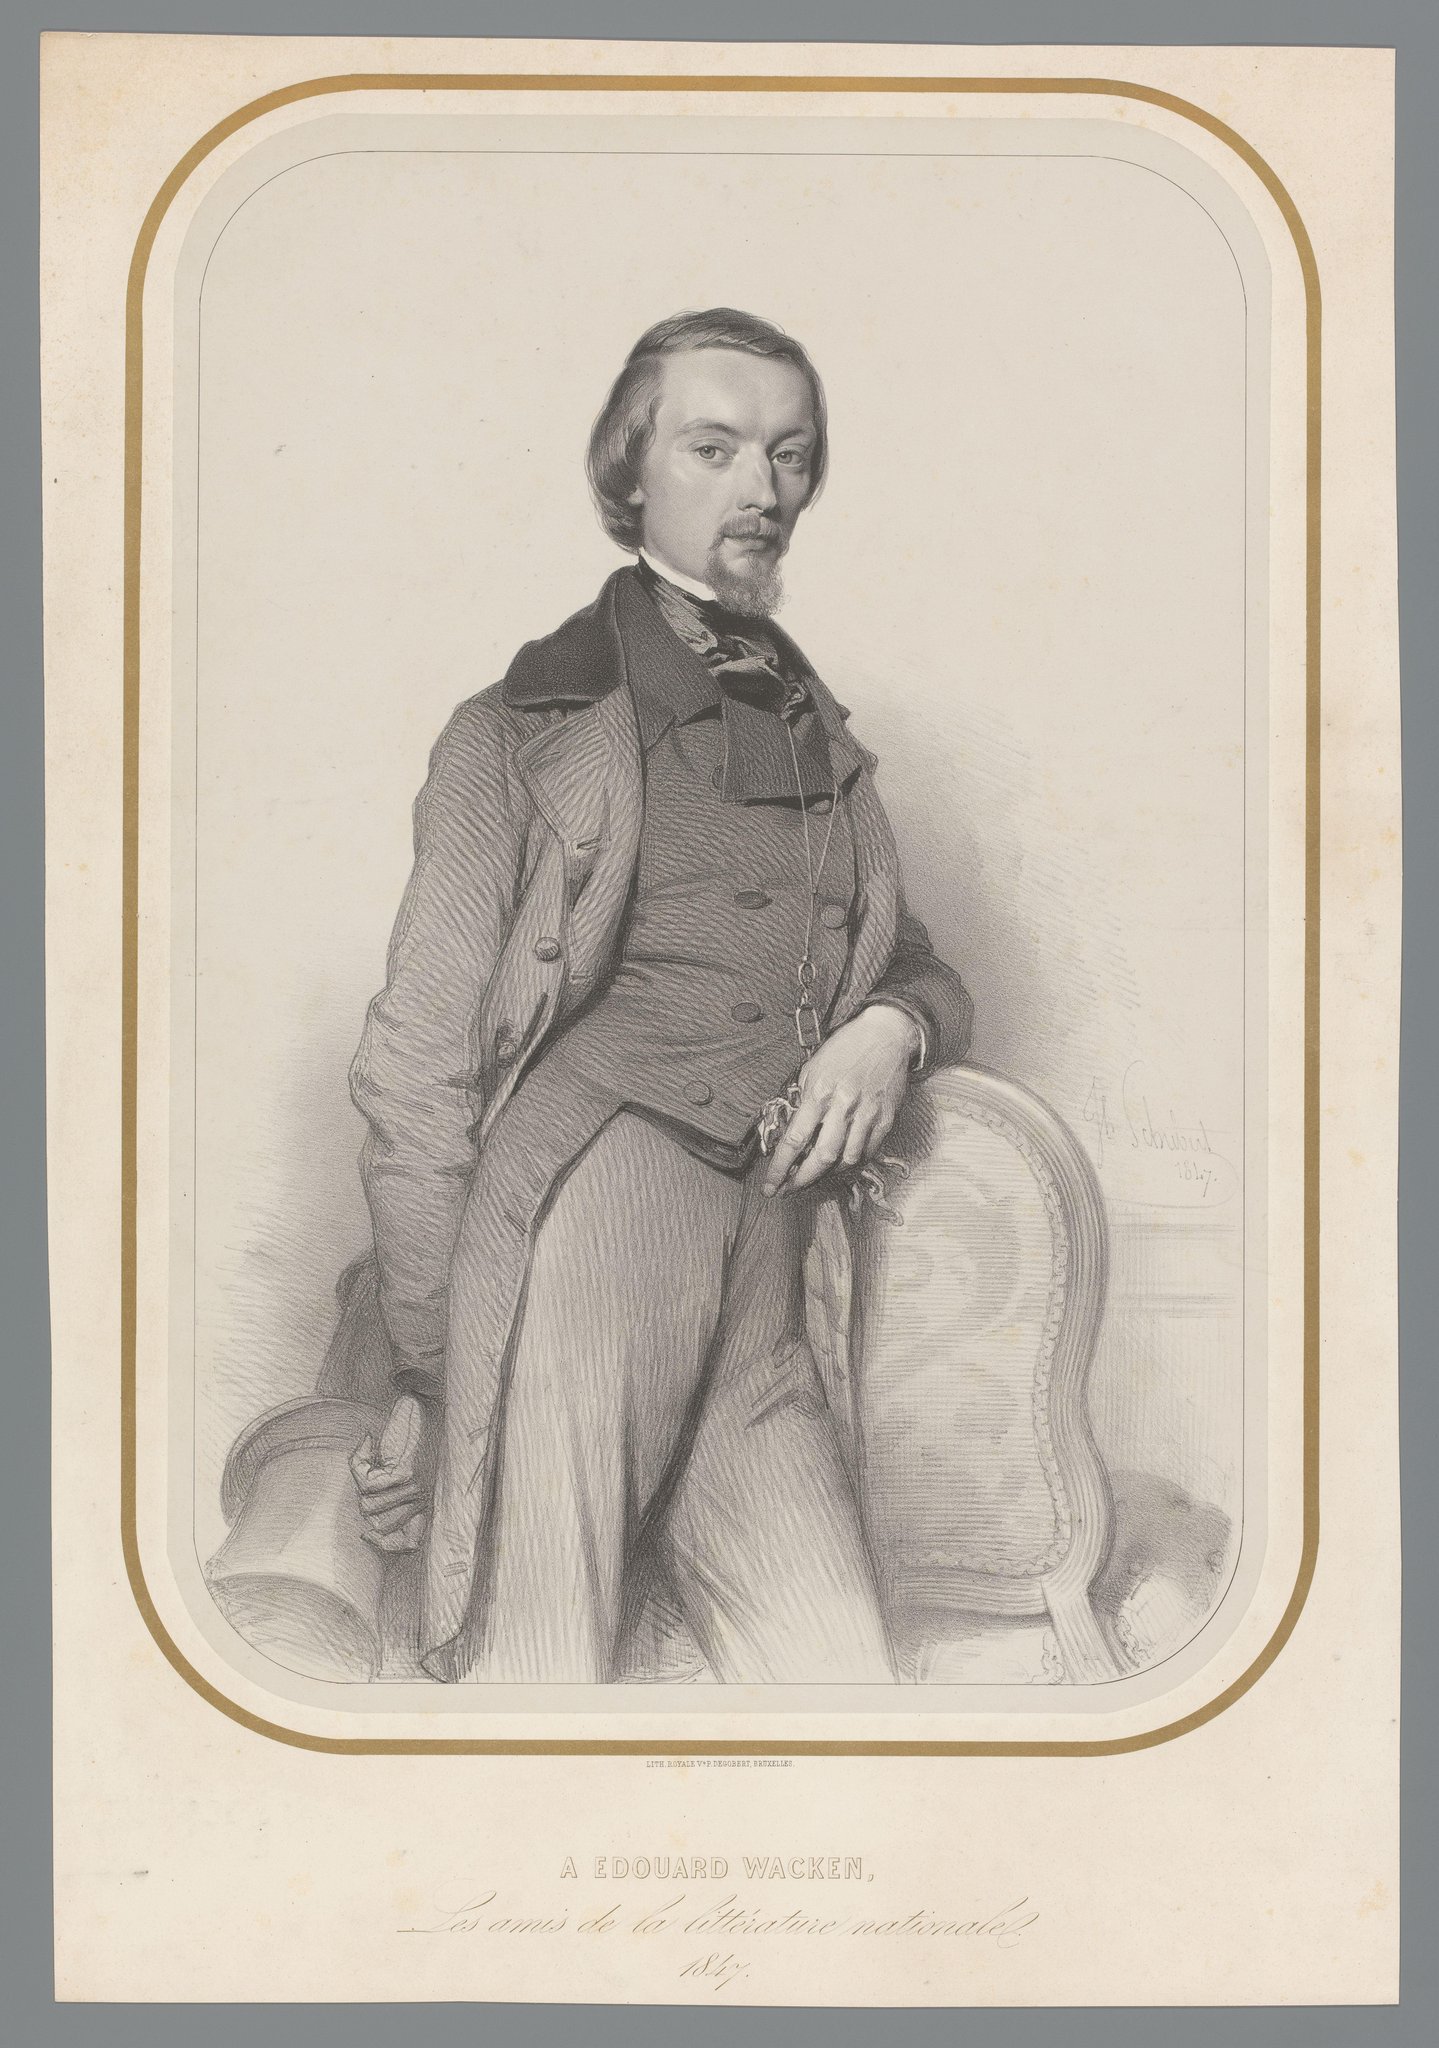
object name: print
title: Portret van Louis Édouard Wacken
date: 1847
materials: paper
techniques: lithograph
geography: brussels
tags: louis édouard wacken, historical persons, portrait of a writer, writer, poet, author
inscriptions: collector's mark: Lugt 2228